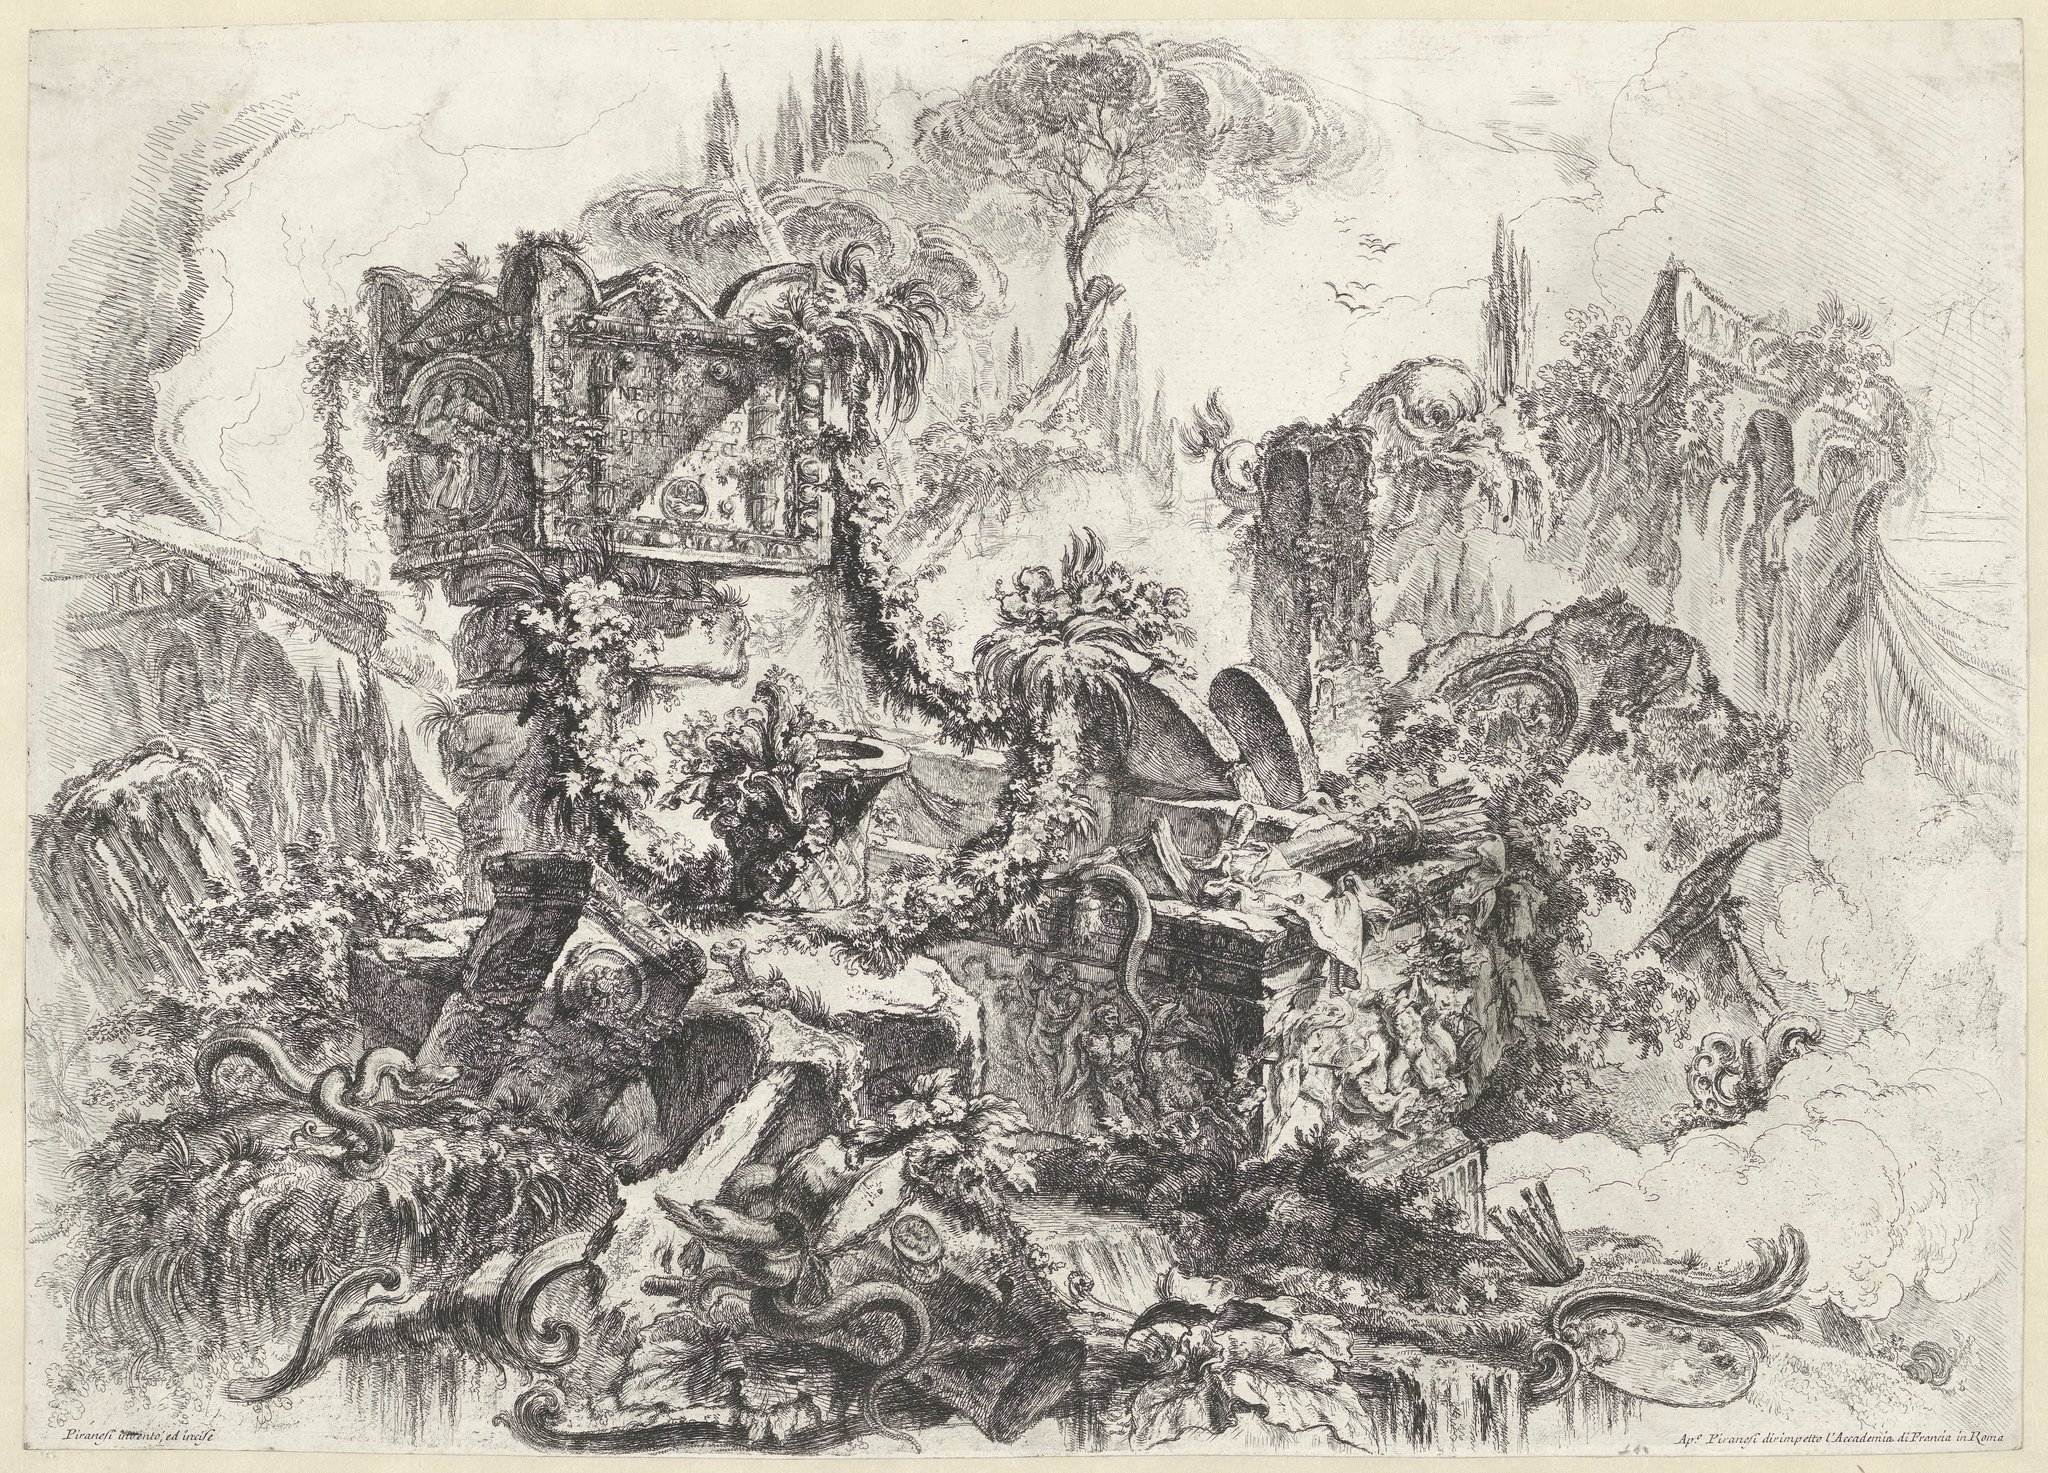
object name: print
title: Tombe van Nero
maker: giovanni battista piranesi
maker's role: designer, draughtsman, print maker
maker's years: 1720-1778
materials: paper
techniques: drypoint, engraving, etching, scoring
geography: rome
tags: snakes, ruin of a building ~ architecture, landscape with ruins, grave, tomb, sarcophagus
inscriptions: collector's mark: Lugt 2760, collector's mark: Lugt 2228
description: Deze prent maakt deel uit van een reeks van 4 prenten met decoratieve fantasiën. Voorheen werd deze reeks 'Capricci decorativi' genoemd. Thans wordt de titel 'Grotteschi' gebruikt. Van deze reeks zijn zes verschillende edities bekend die dateren tussen 1747 en ca. 1940 (Zie Robison 1986, p. 115).